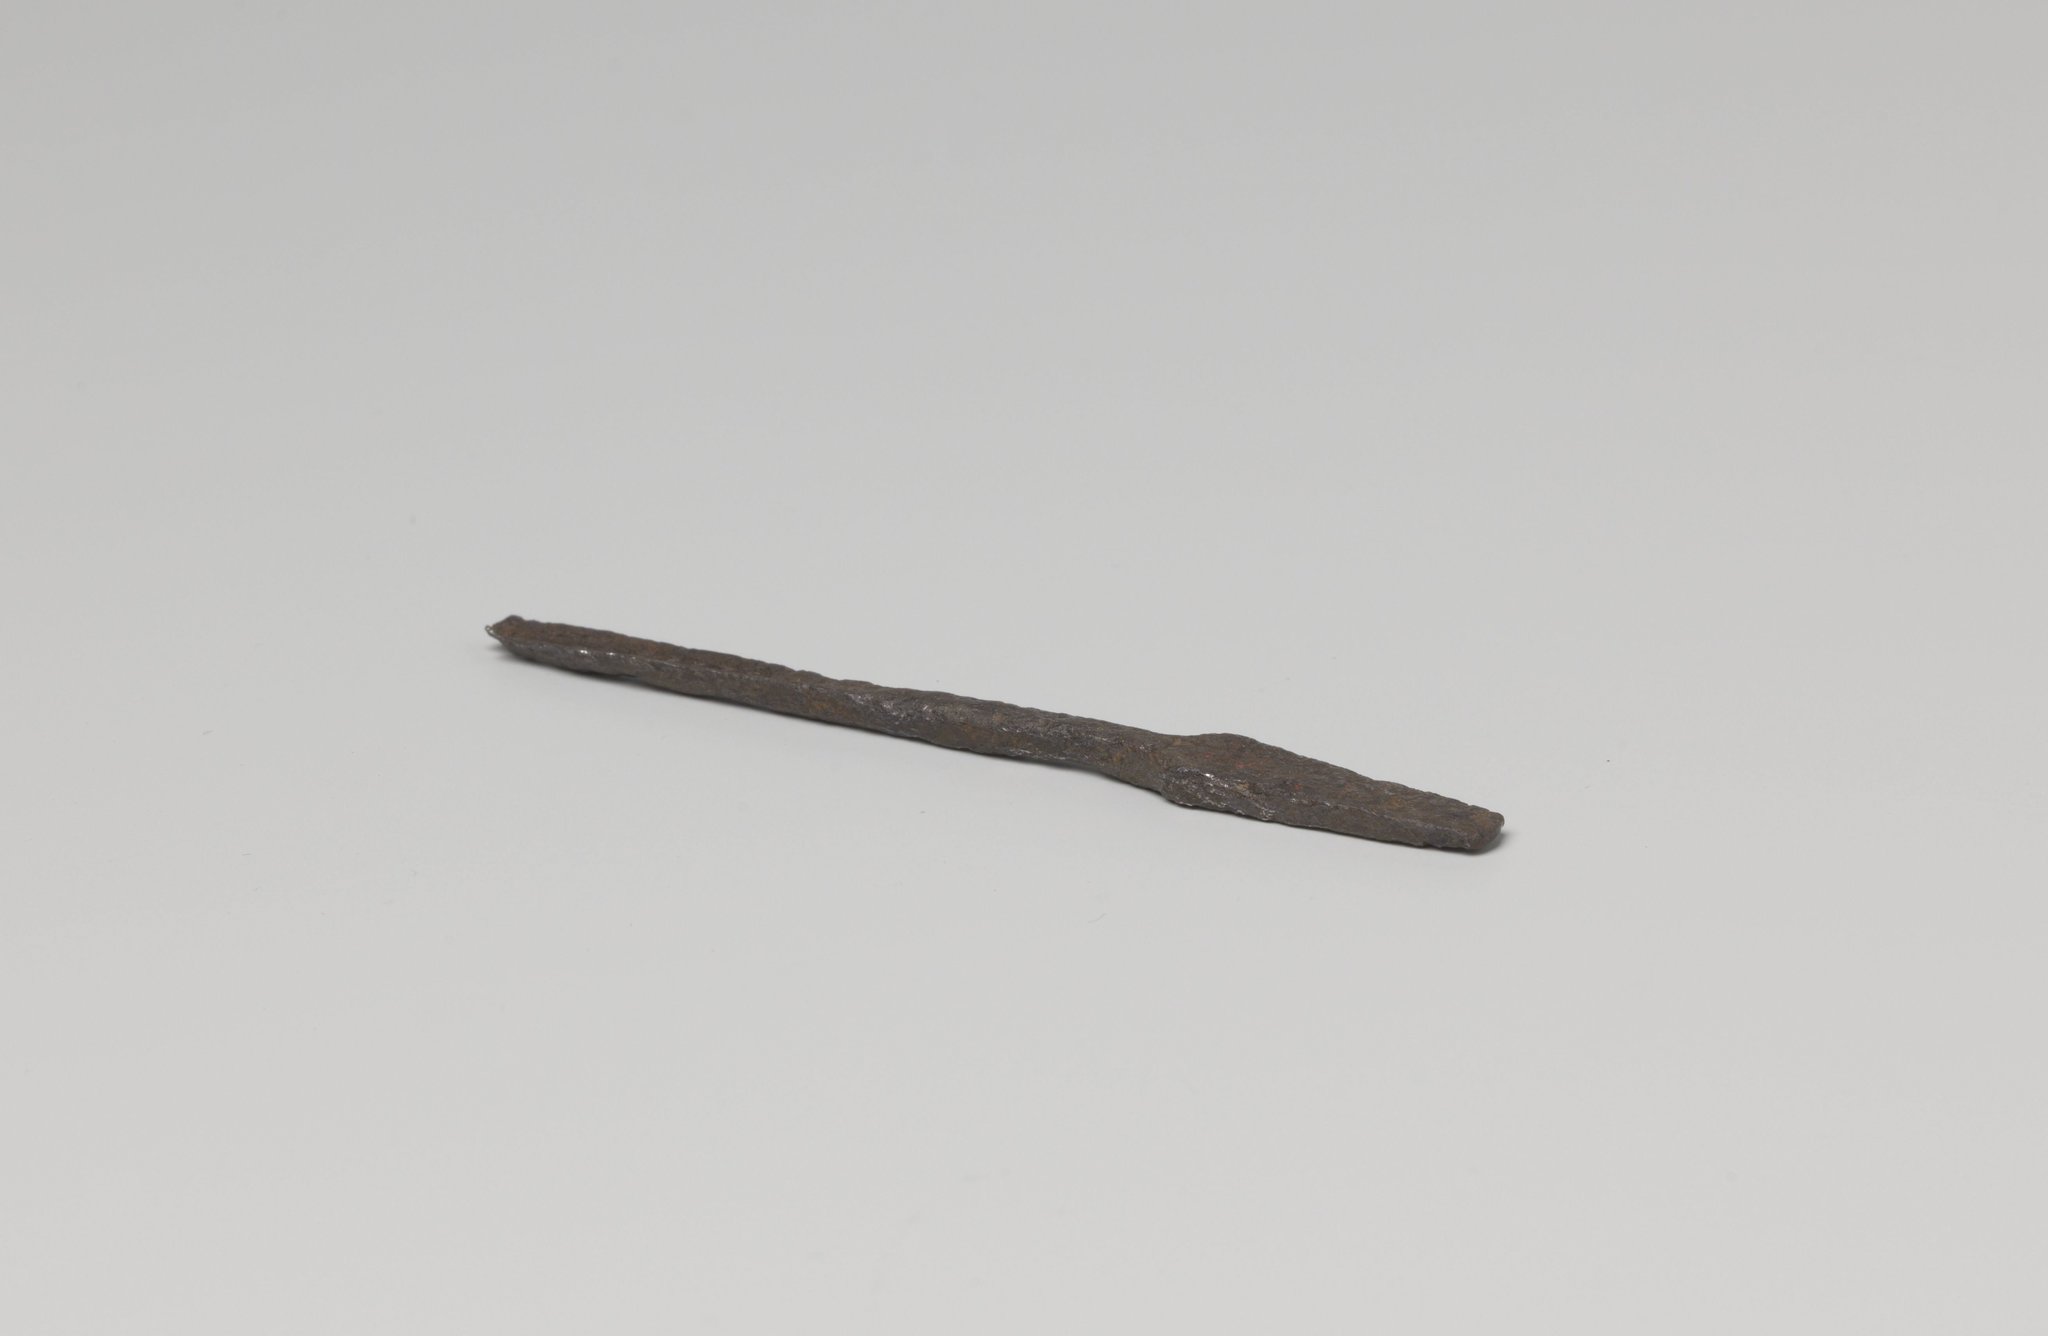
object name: bit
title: Fragment van boorijzer, aan het ene uiteinde plat en aan het ander uiteinde met gleuf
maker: Anonymous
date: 1590-1596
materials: iron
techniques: forging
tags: willem barendsz., amsterdam, jacob van heemskerck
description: Fragment van een boorijzer, aan het ene uiteinde een gleuf (als een guts) en aan het andere uiteinde rechthoekig plat.